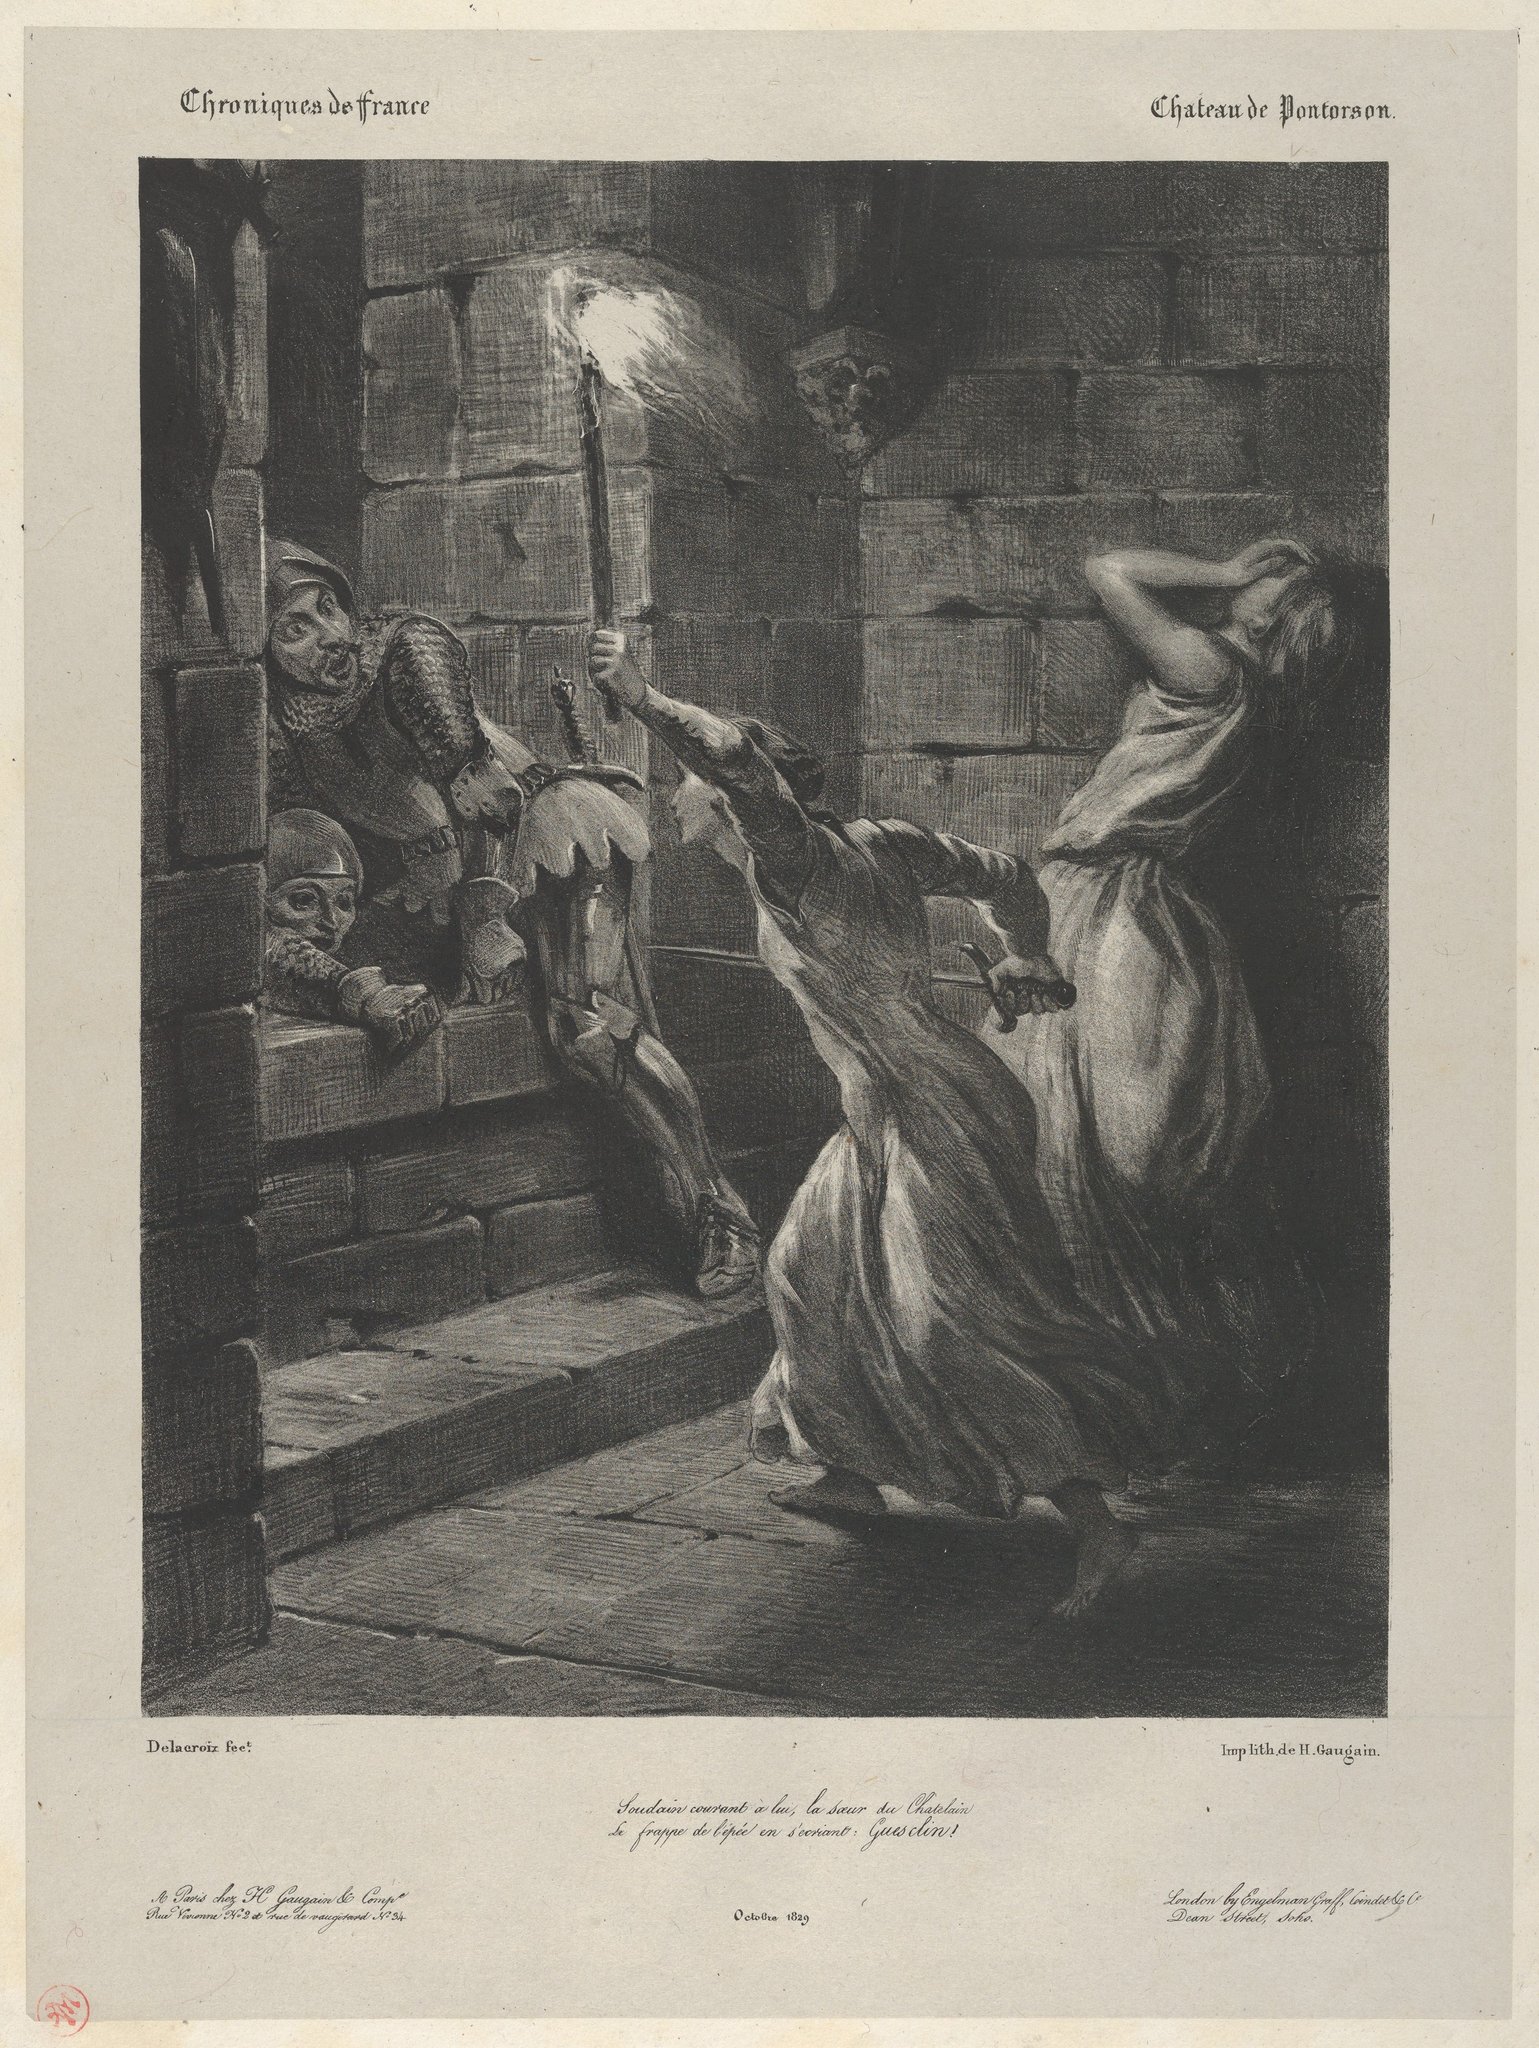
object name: print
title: Duguesclin's Sister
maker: eugène delacroix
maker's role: artist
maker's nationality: french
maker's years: 1798-1863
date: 1829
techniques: lithograph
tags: soldiers,men,women